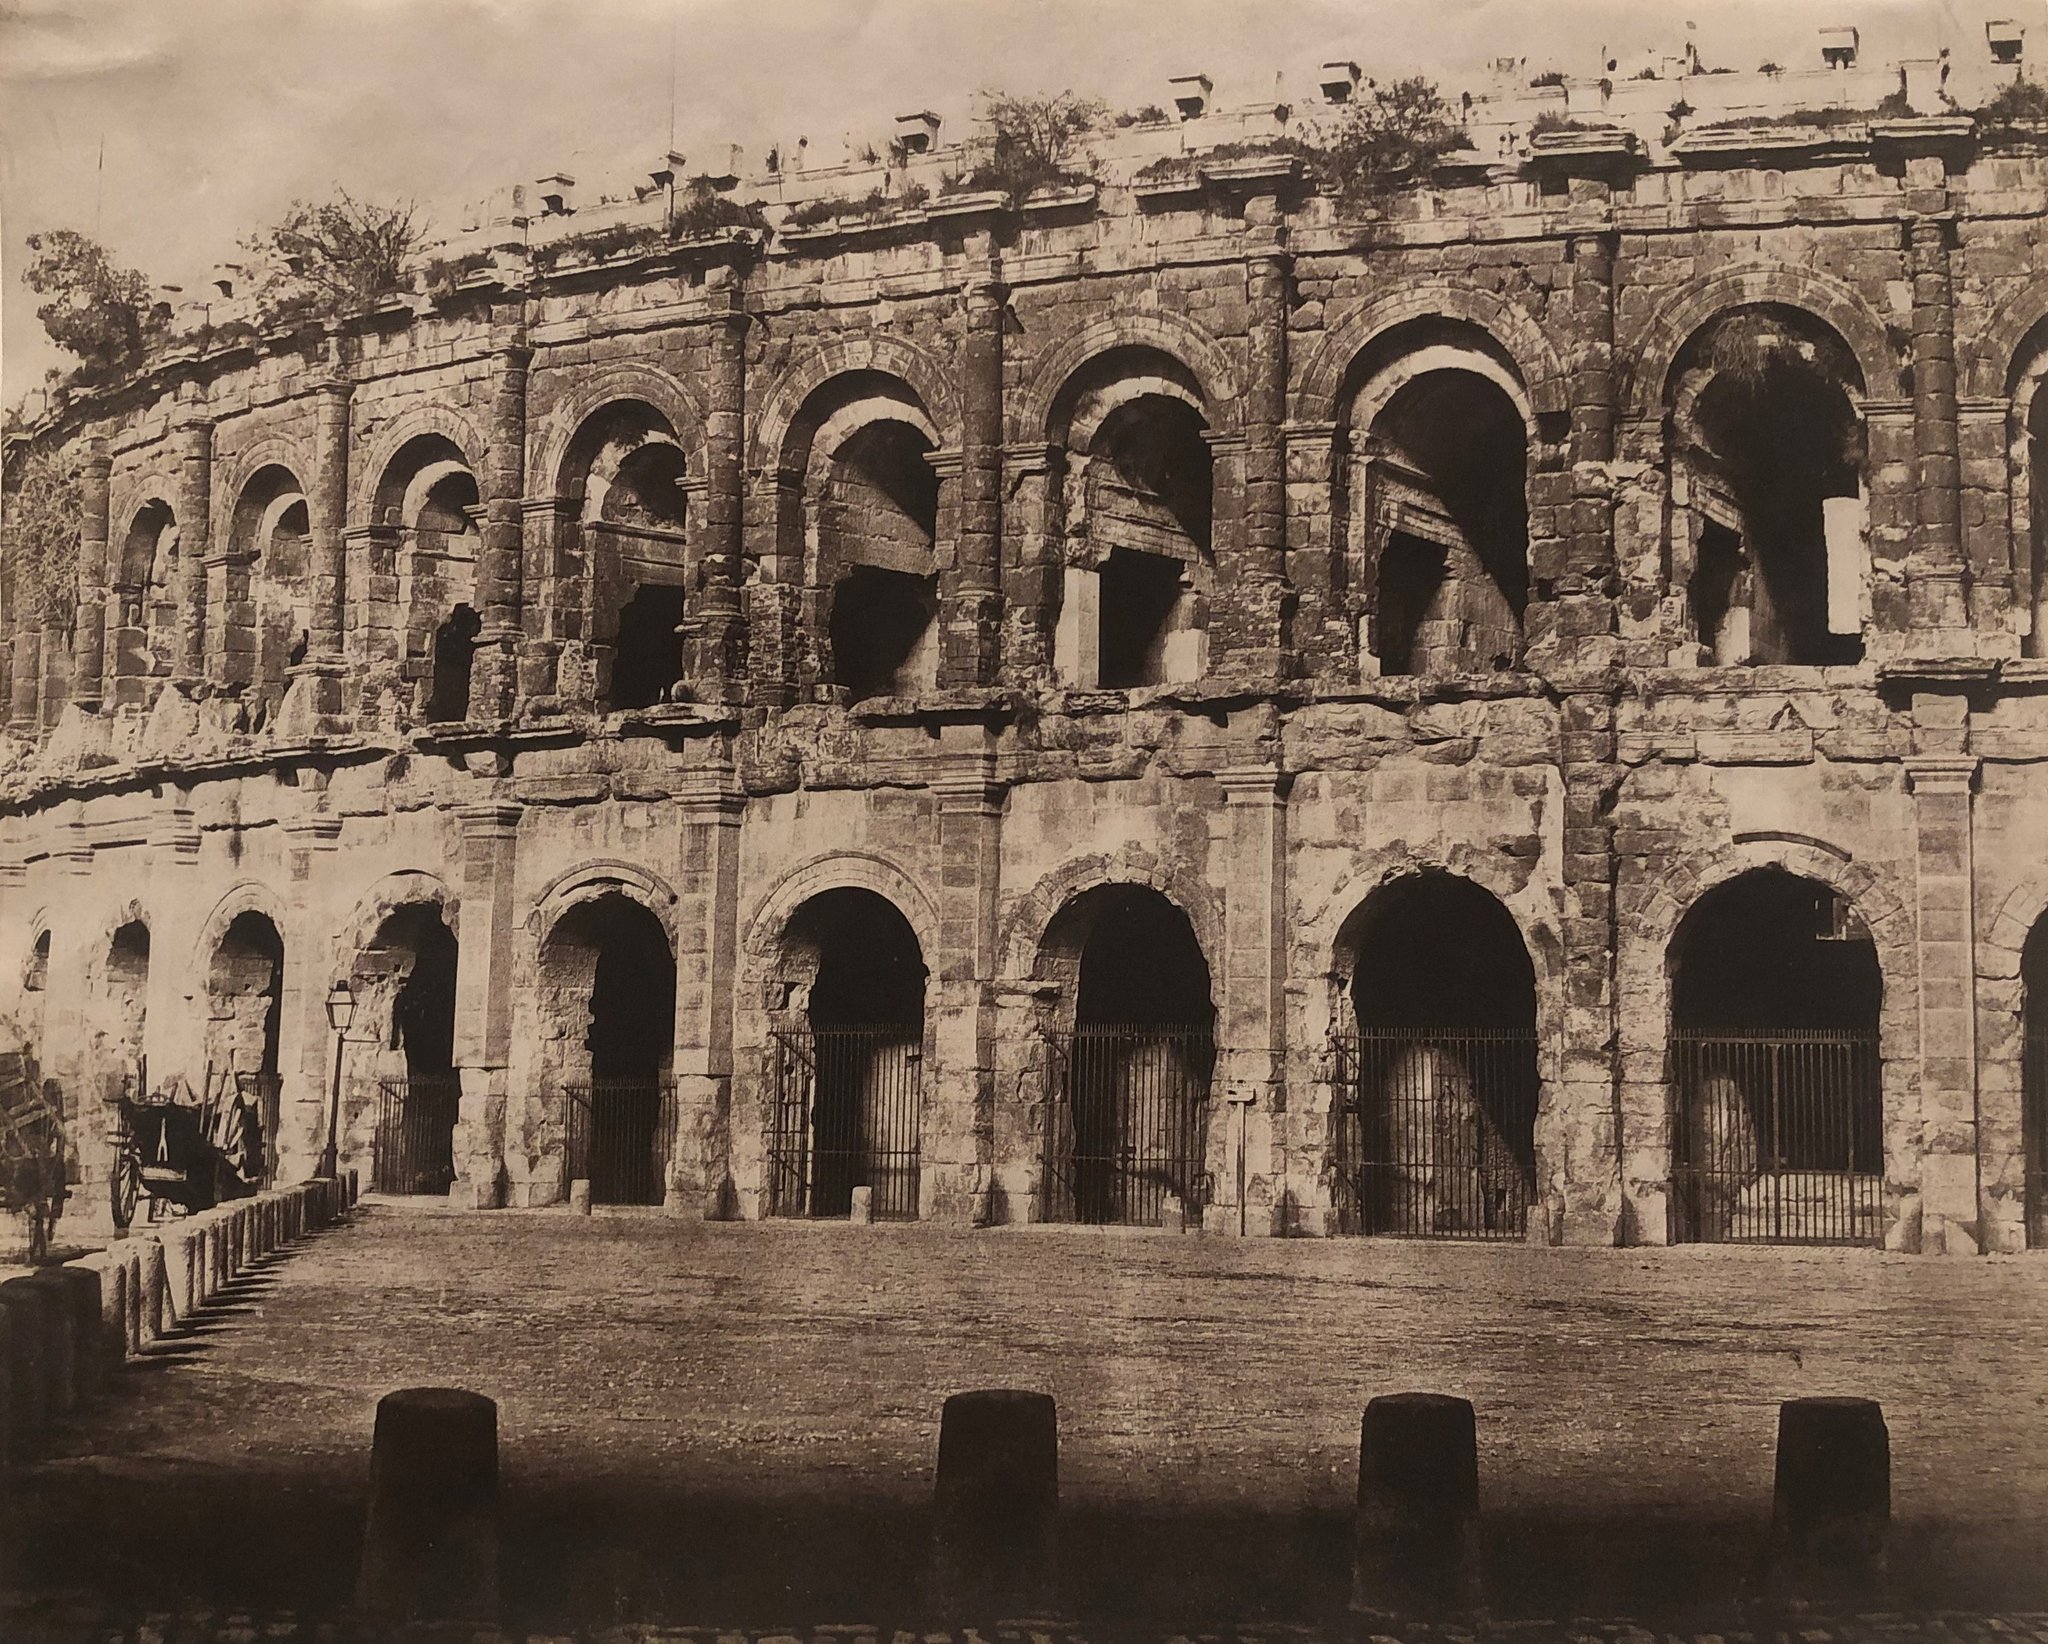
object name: photograph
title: [Amphitheater, Nîmes]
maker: édouard denis baldus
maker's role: fotograaf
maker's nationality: french, born prussia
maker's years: 1813-1889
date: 1853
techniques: paper negative, salted paper print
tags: architecture,amphitheatres